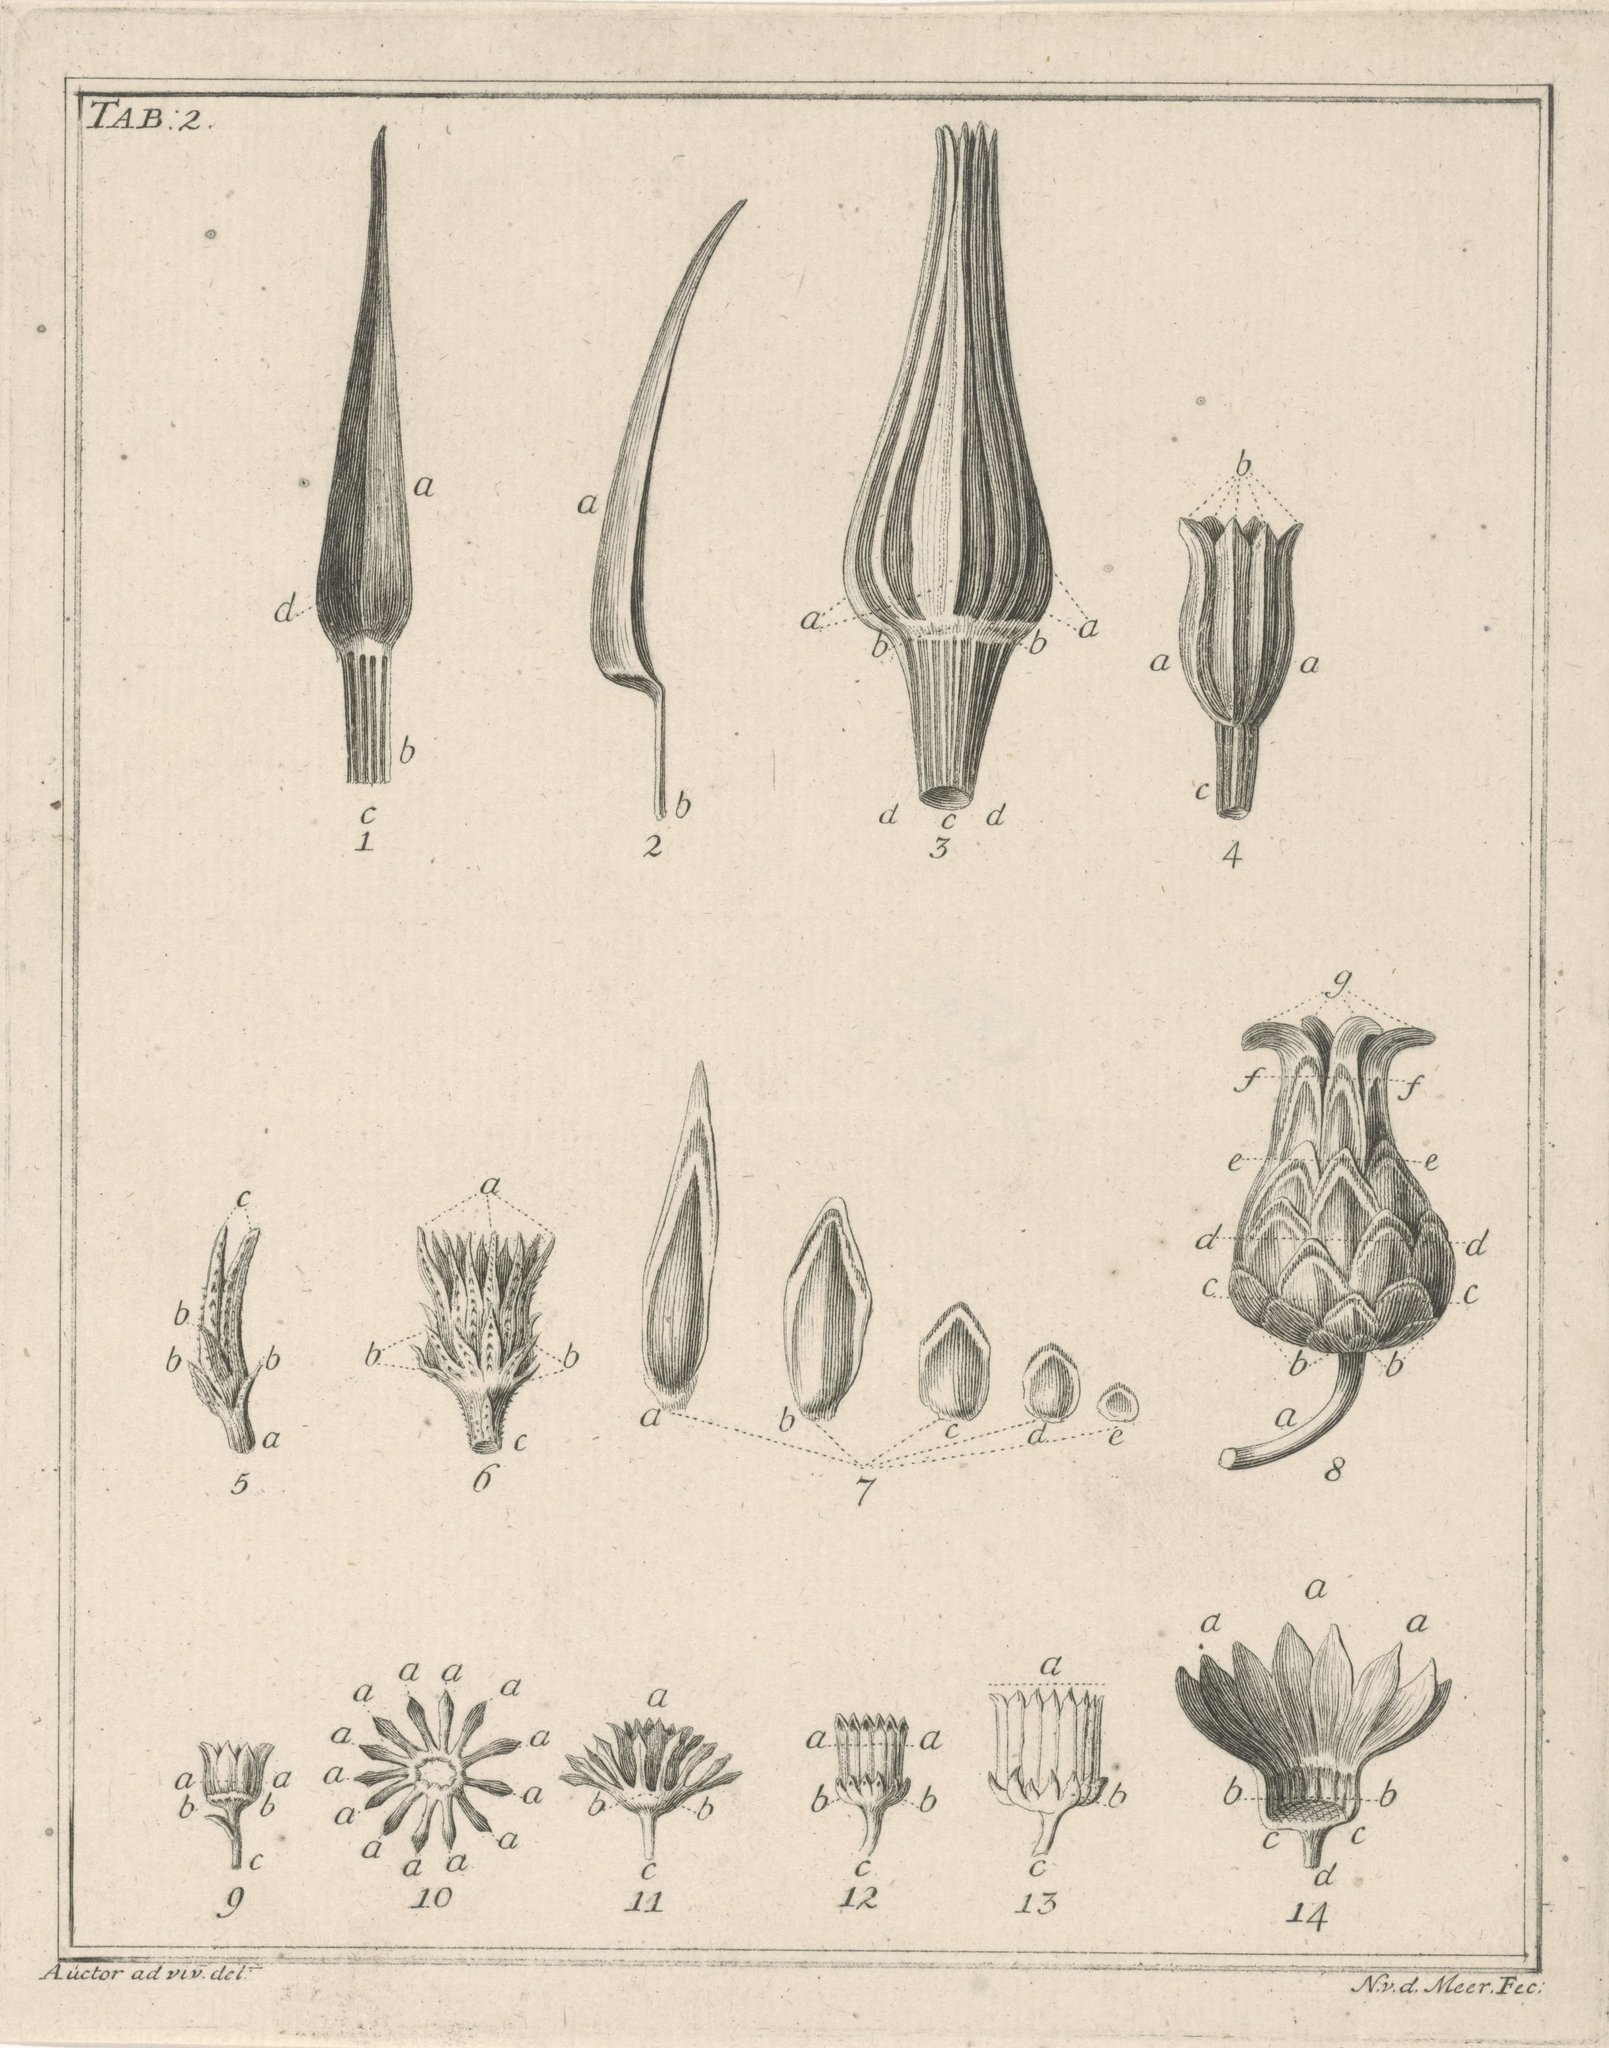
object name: print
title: Bloemen, Tab. 2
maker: Anonymous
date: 1751-1822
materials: paper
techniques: etching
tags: flowers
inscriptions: collector's mark: Lugt 2228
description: Bloemenknoppen en andere onderdelen van bloemen. Linksboven: Tab. 2.